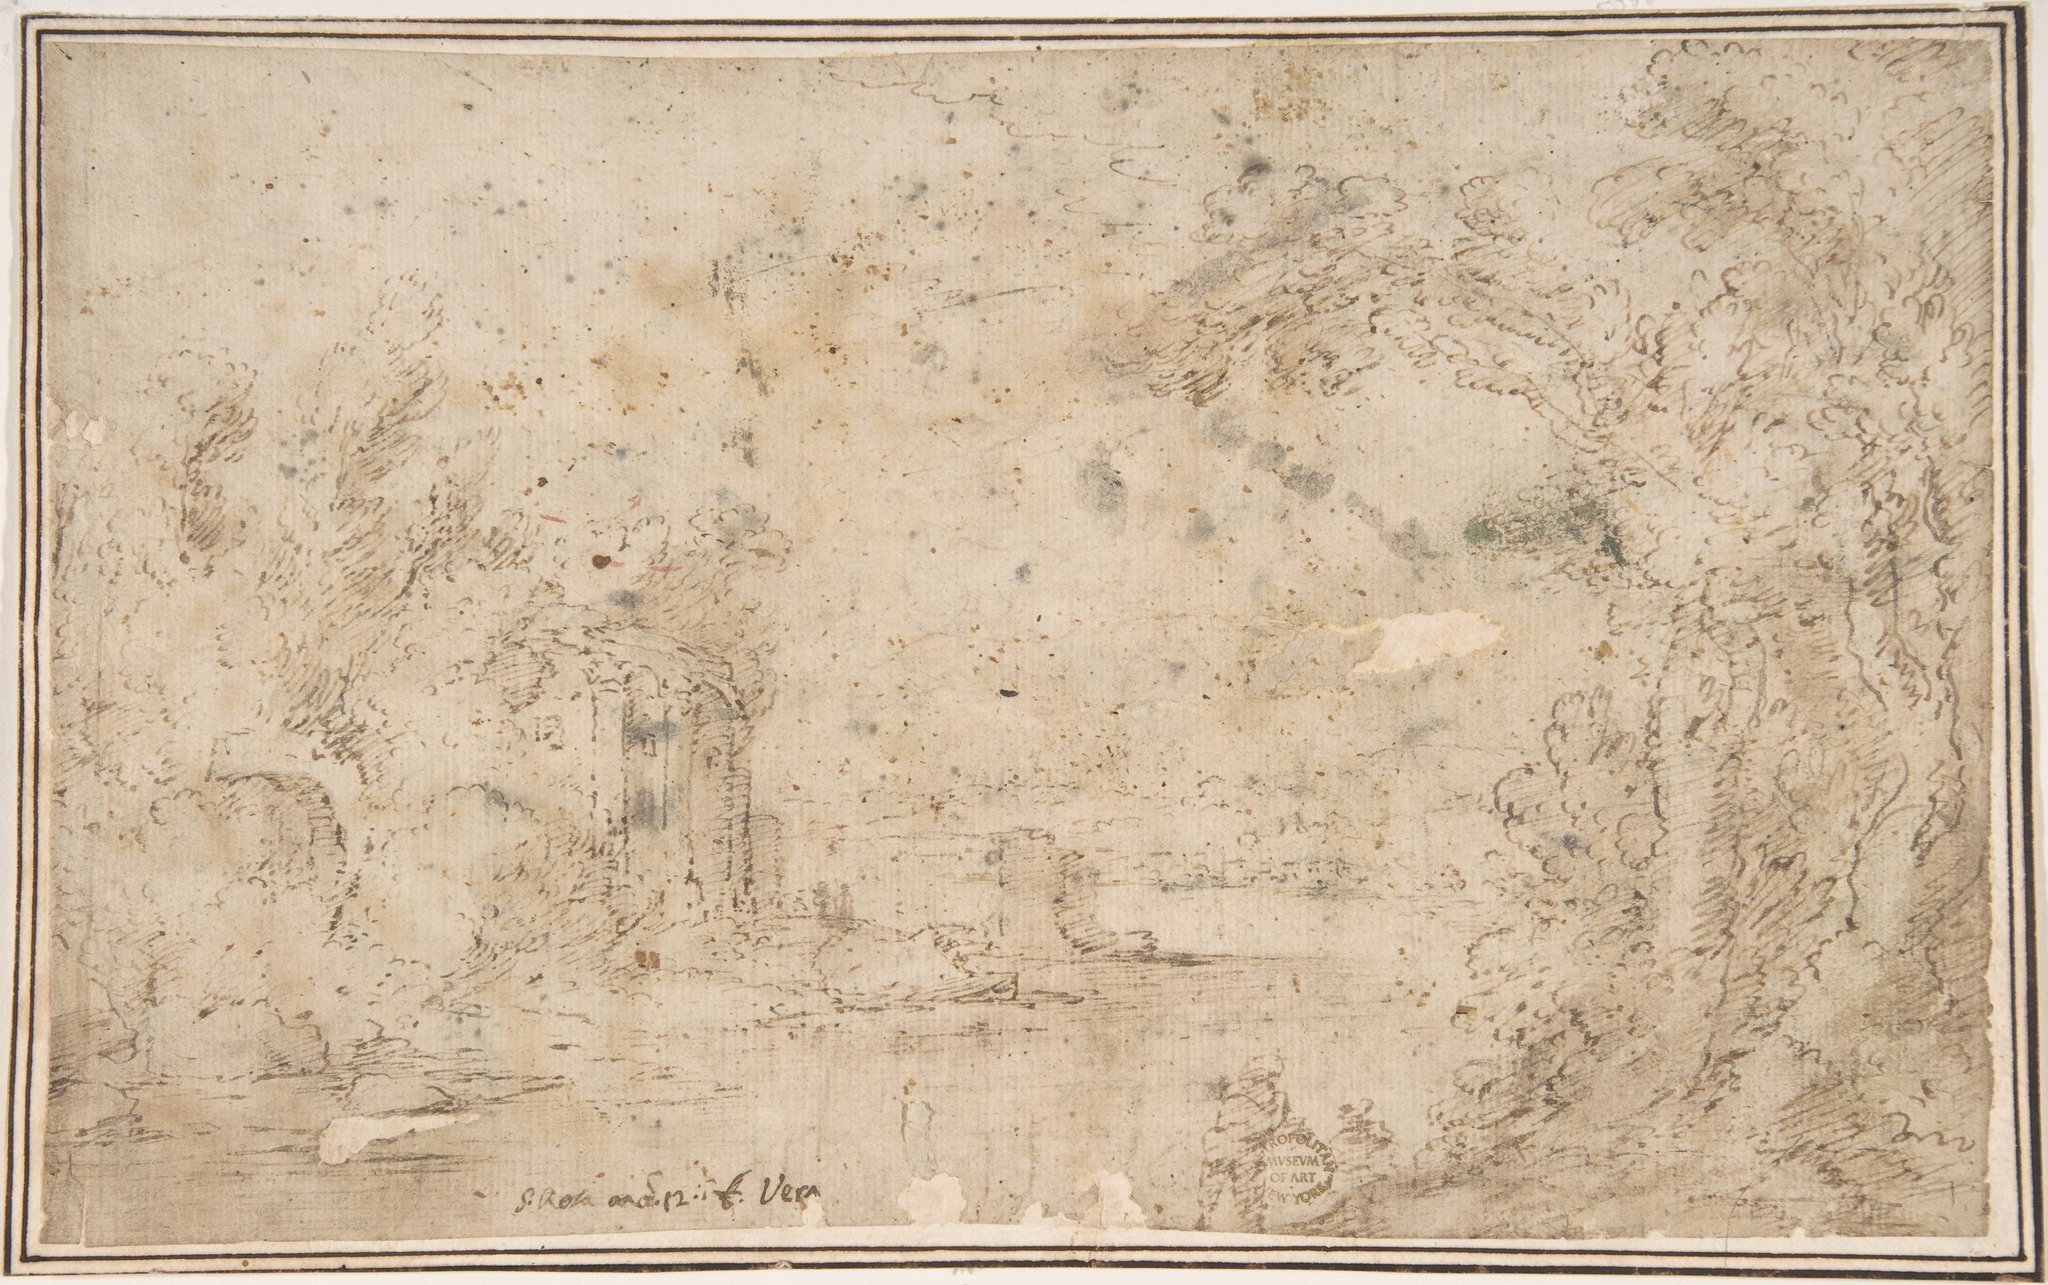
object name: drawing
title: Landscape with Ruins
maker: anonymous, italian, roman-bolognese, 17th century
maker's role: artist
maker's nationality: italian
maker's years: 1600-1700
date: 1601-1700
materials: ink, paper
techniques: brush, pen, wash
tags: ruins,landscapes